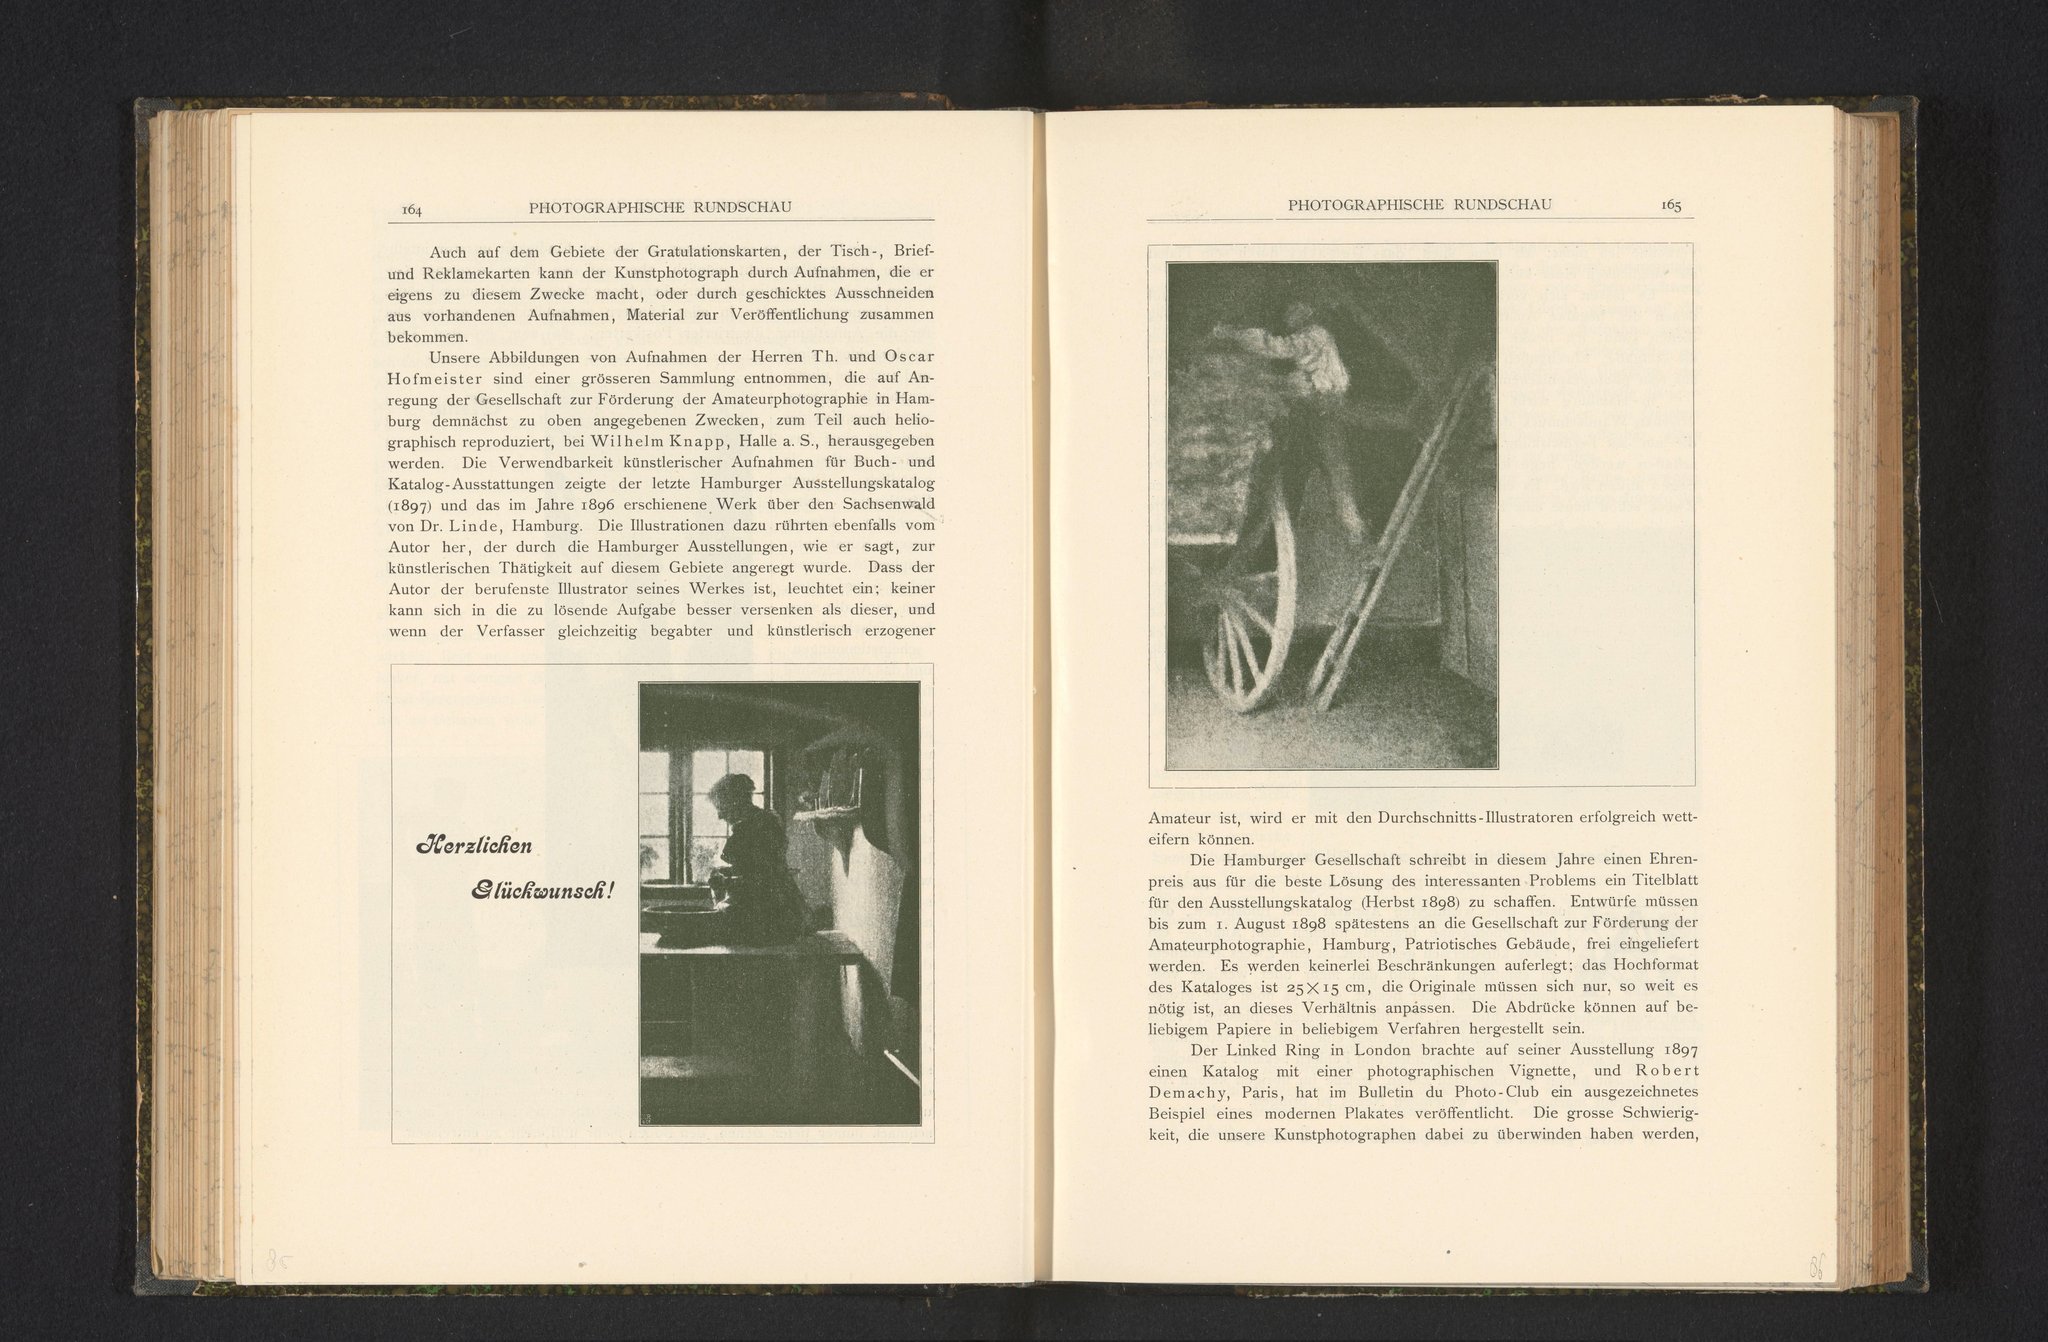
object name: page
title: Vrouw voor een venster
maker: Anonymous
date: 1893-1898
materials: paper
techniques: autotype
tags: adult woman, closed window